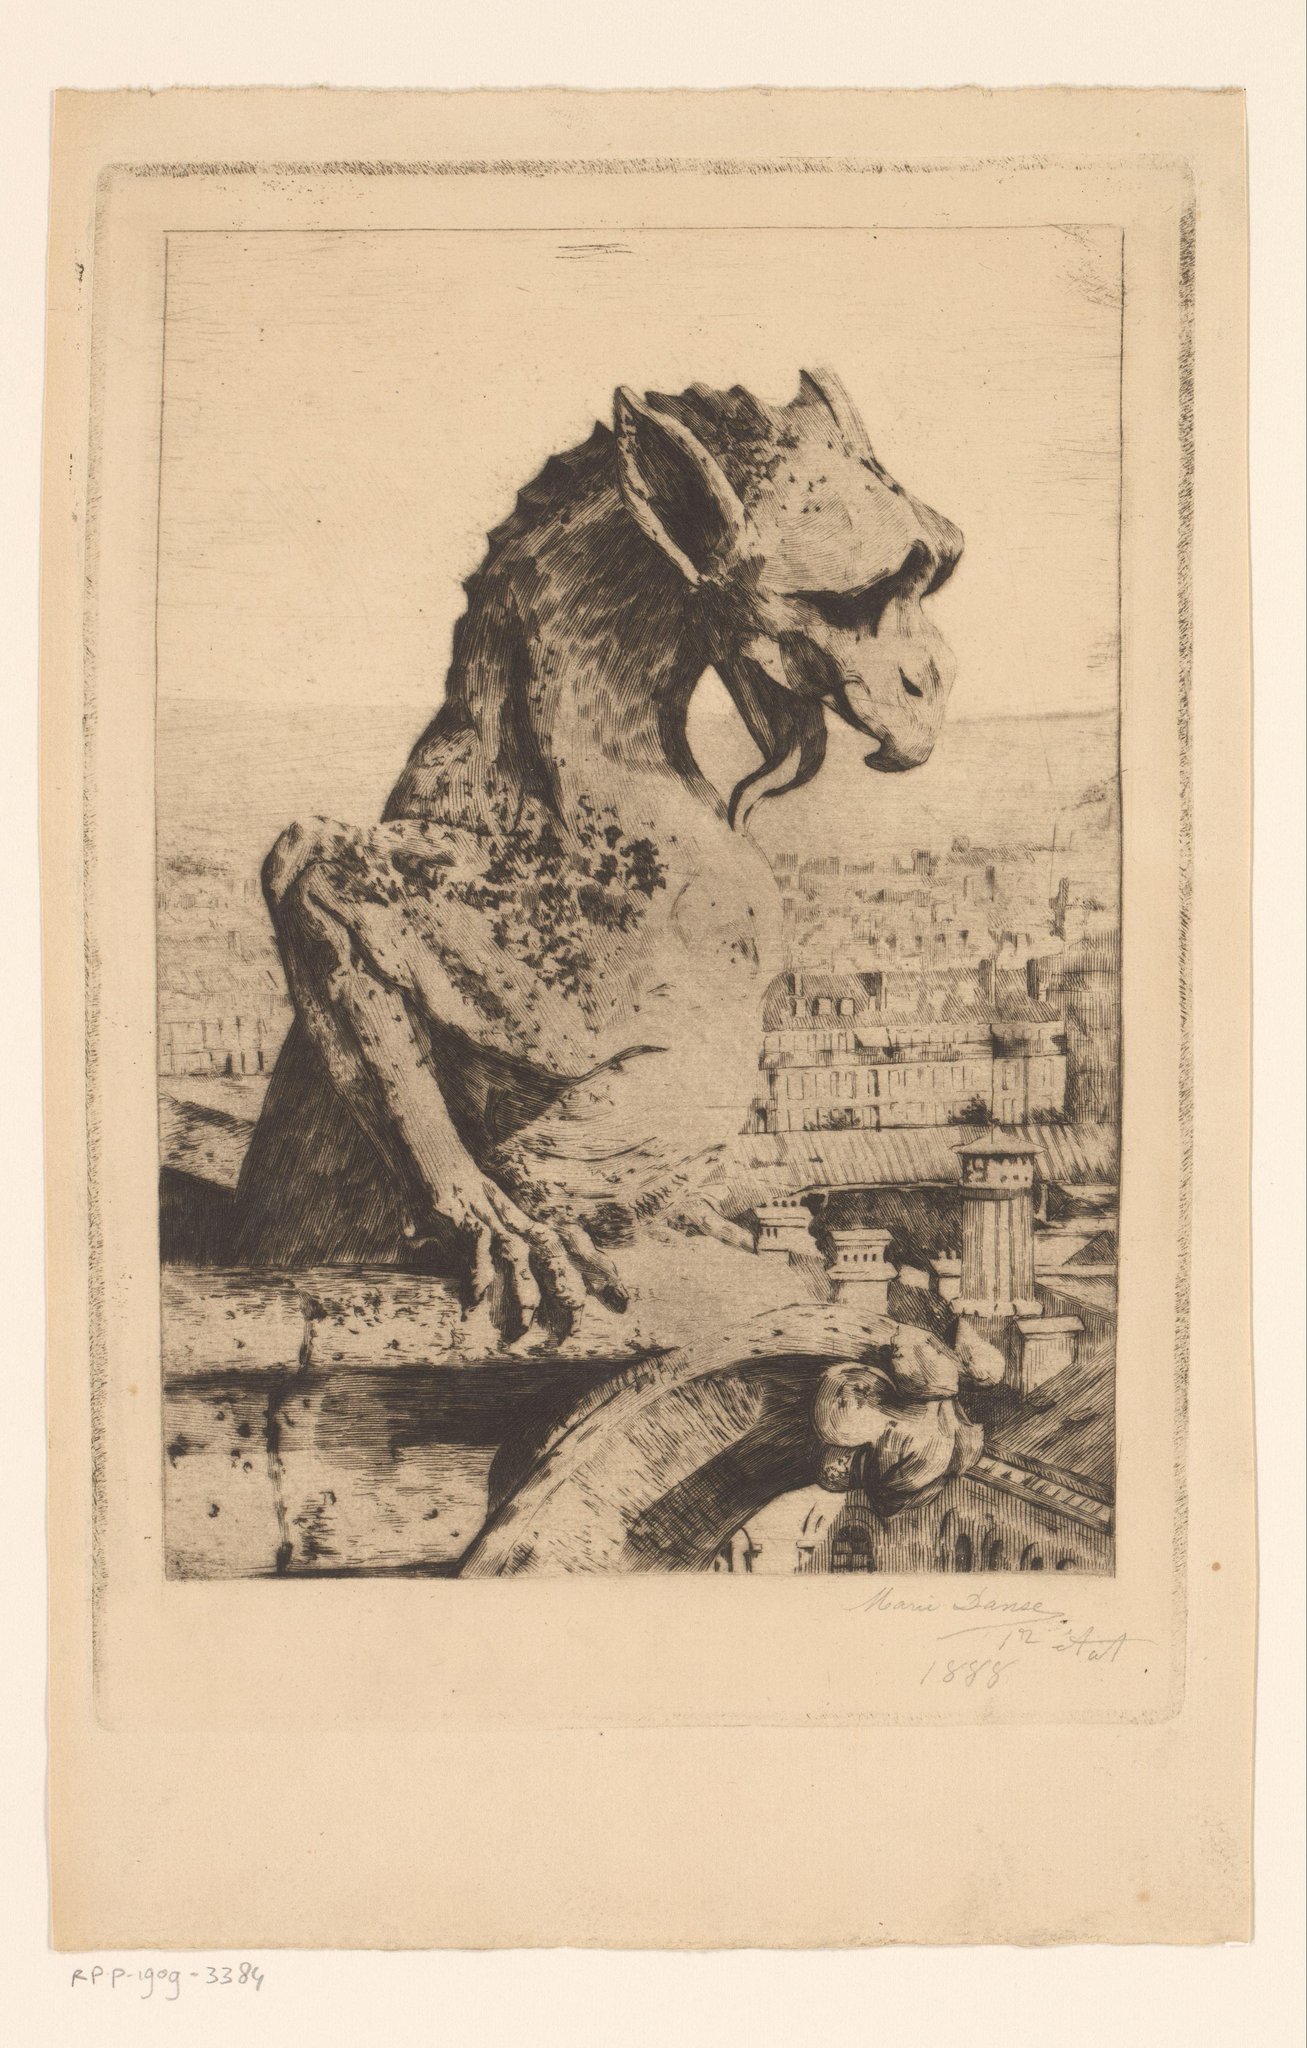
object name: print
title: Waterspuwer van de Notre-Dame te Parijs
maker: marie danse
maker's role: print maker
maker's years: 1867-1942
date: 1888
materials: paper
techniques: drypoint, etching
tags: ornament ~ hybrid animals, piece of sculpture, reproduction of a piece of sculpture, parts of church exterior and annexes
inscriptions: inscription: ‘1e état’, collector's mark: Lugt 2228